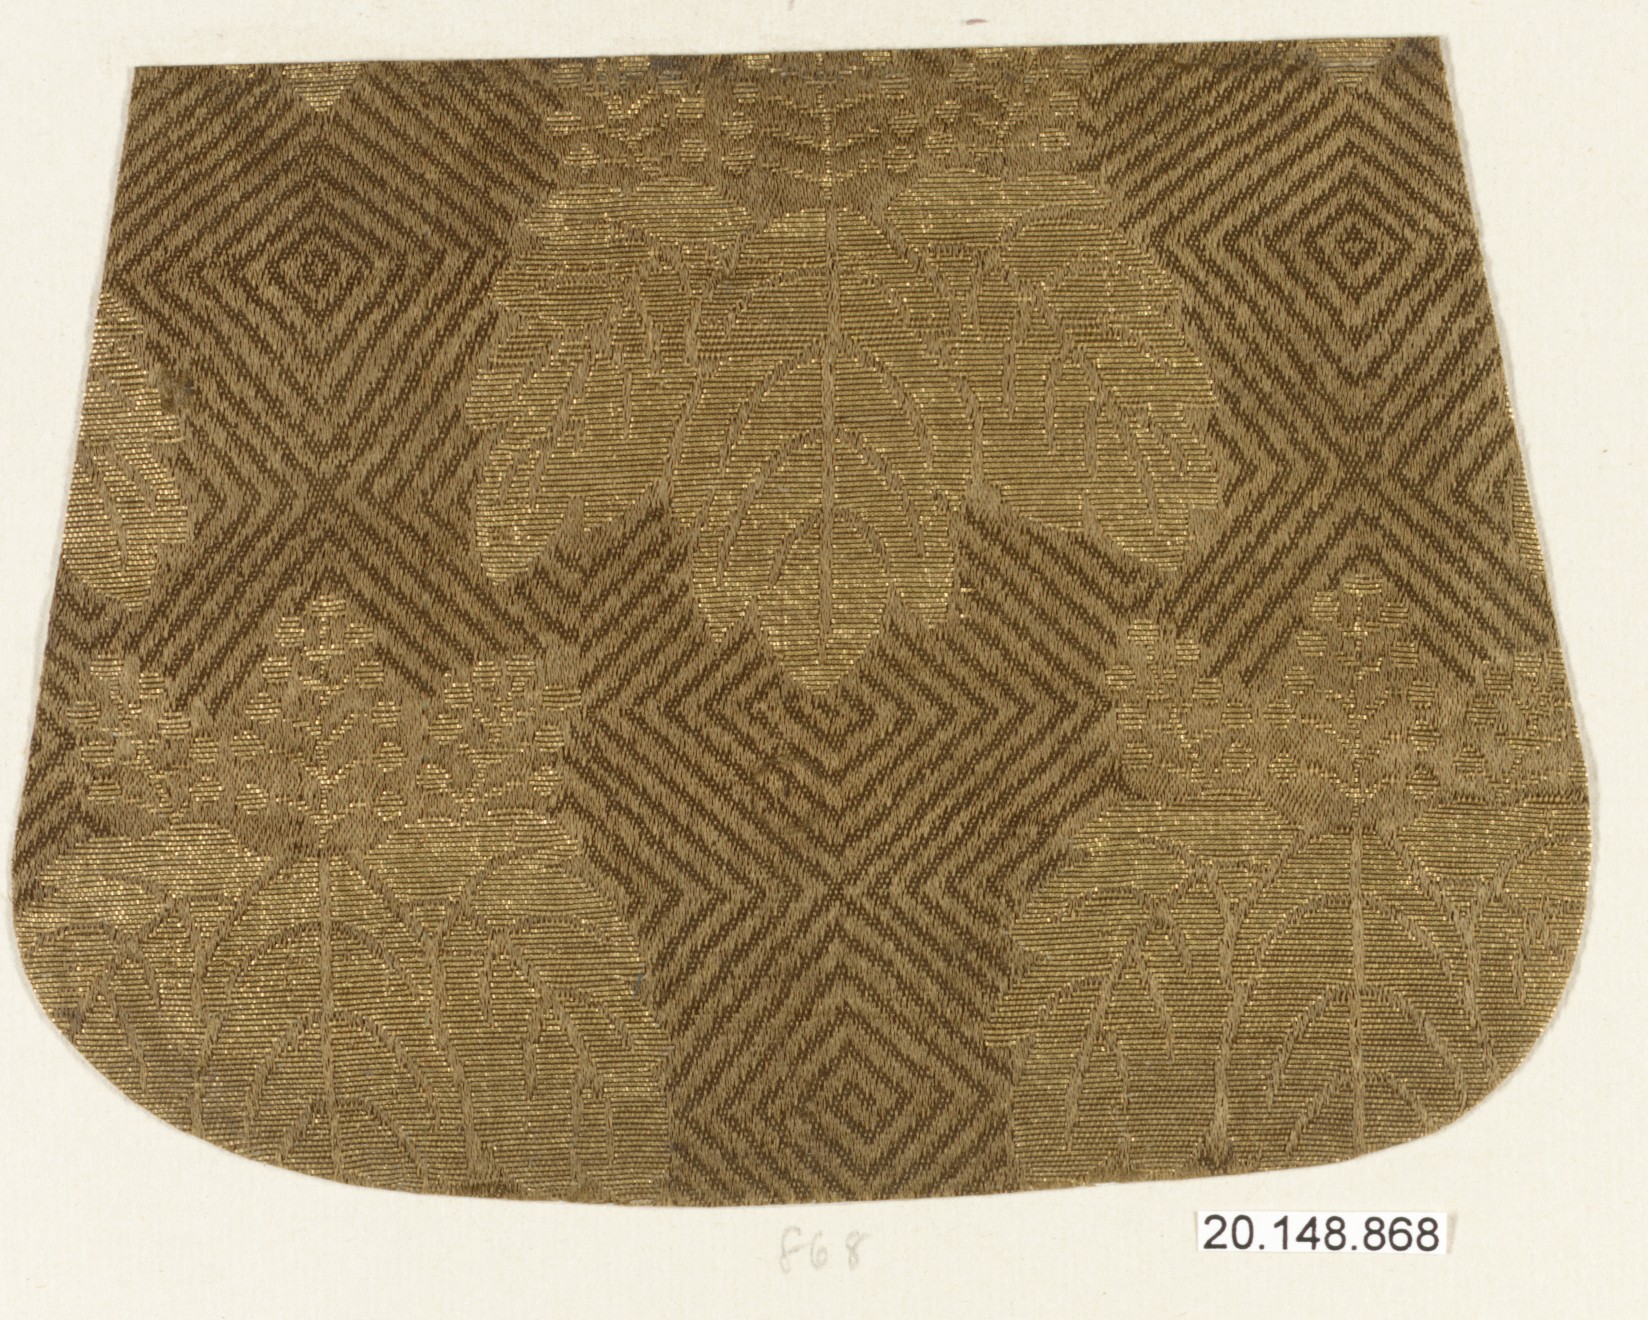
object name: piece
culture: japanese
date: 1601-1700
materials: silk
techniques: compound weave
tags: leaves